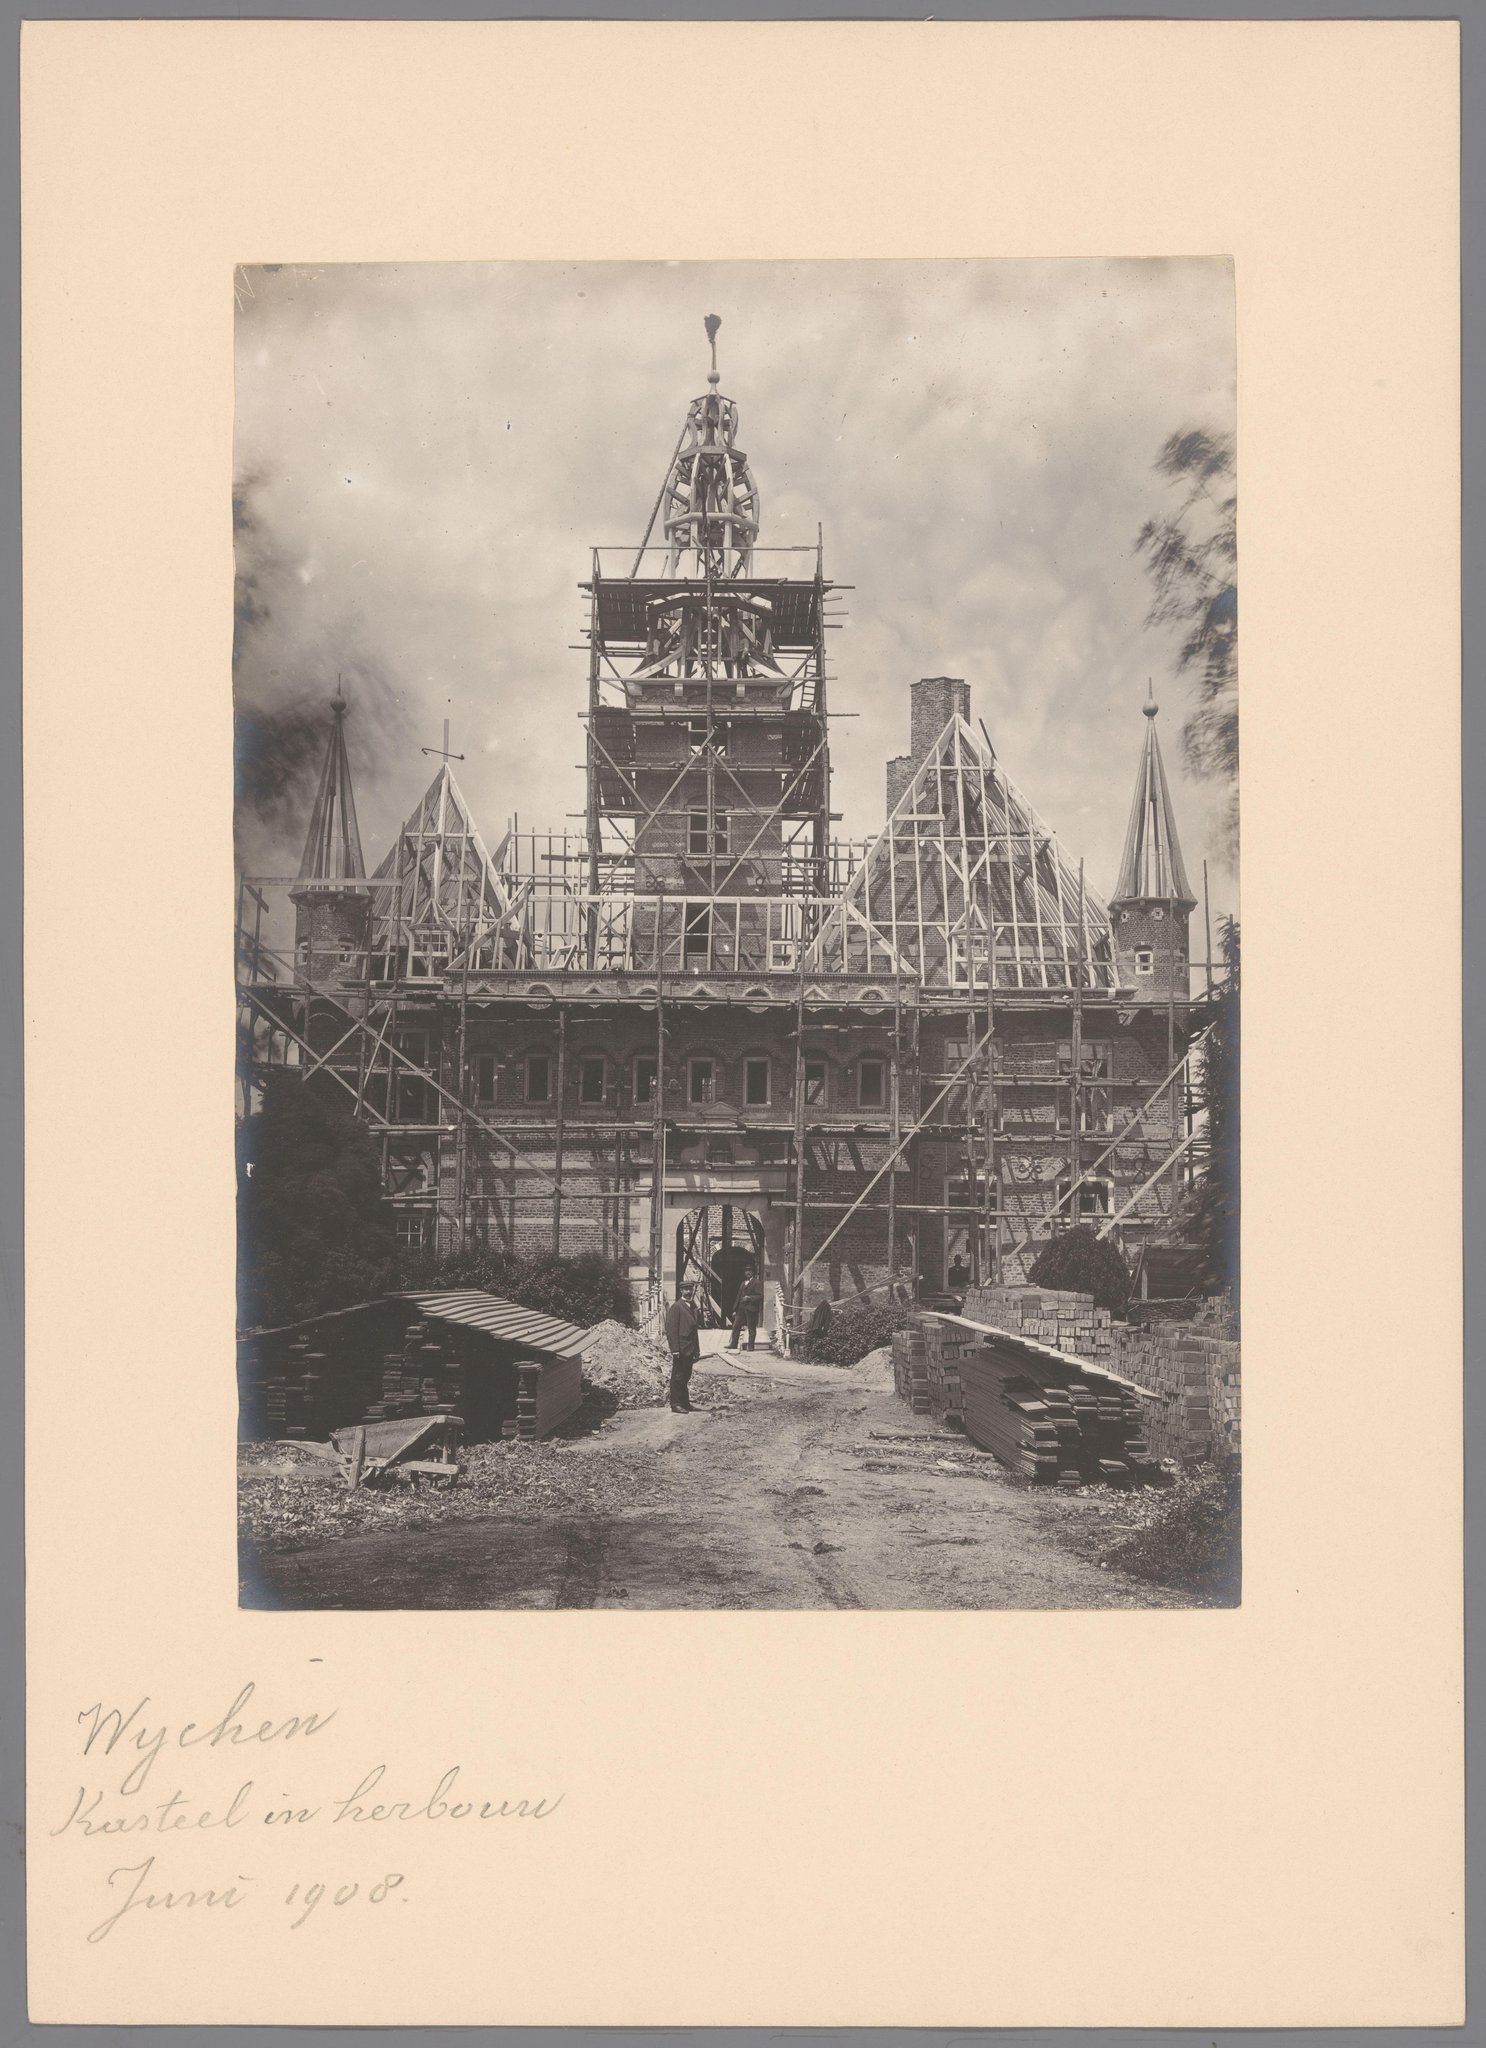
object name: photograph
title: Herbouw van het Kasteel van Wijchen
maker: anoniem (monumentenzorg)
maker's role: fotograaf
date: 1908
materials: cardboard, photographic support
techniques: gelatin silver print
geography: wijchen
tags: castle, landscape with tower or castle (+ city(-scape) with figures, staffage)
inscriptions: annotation: ‘Wijchen/ Kasteel in herbouw/ Juni 1908’